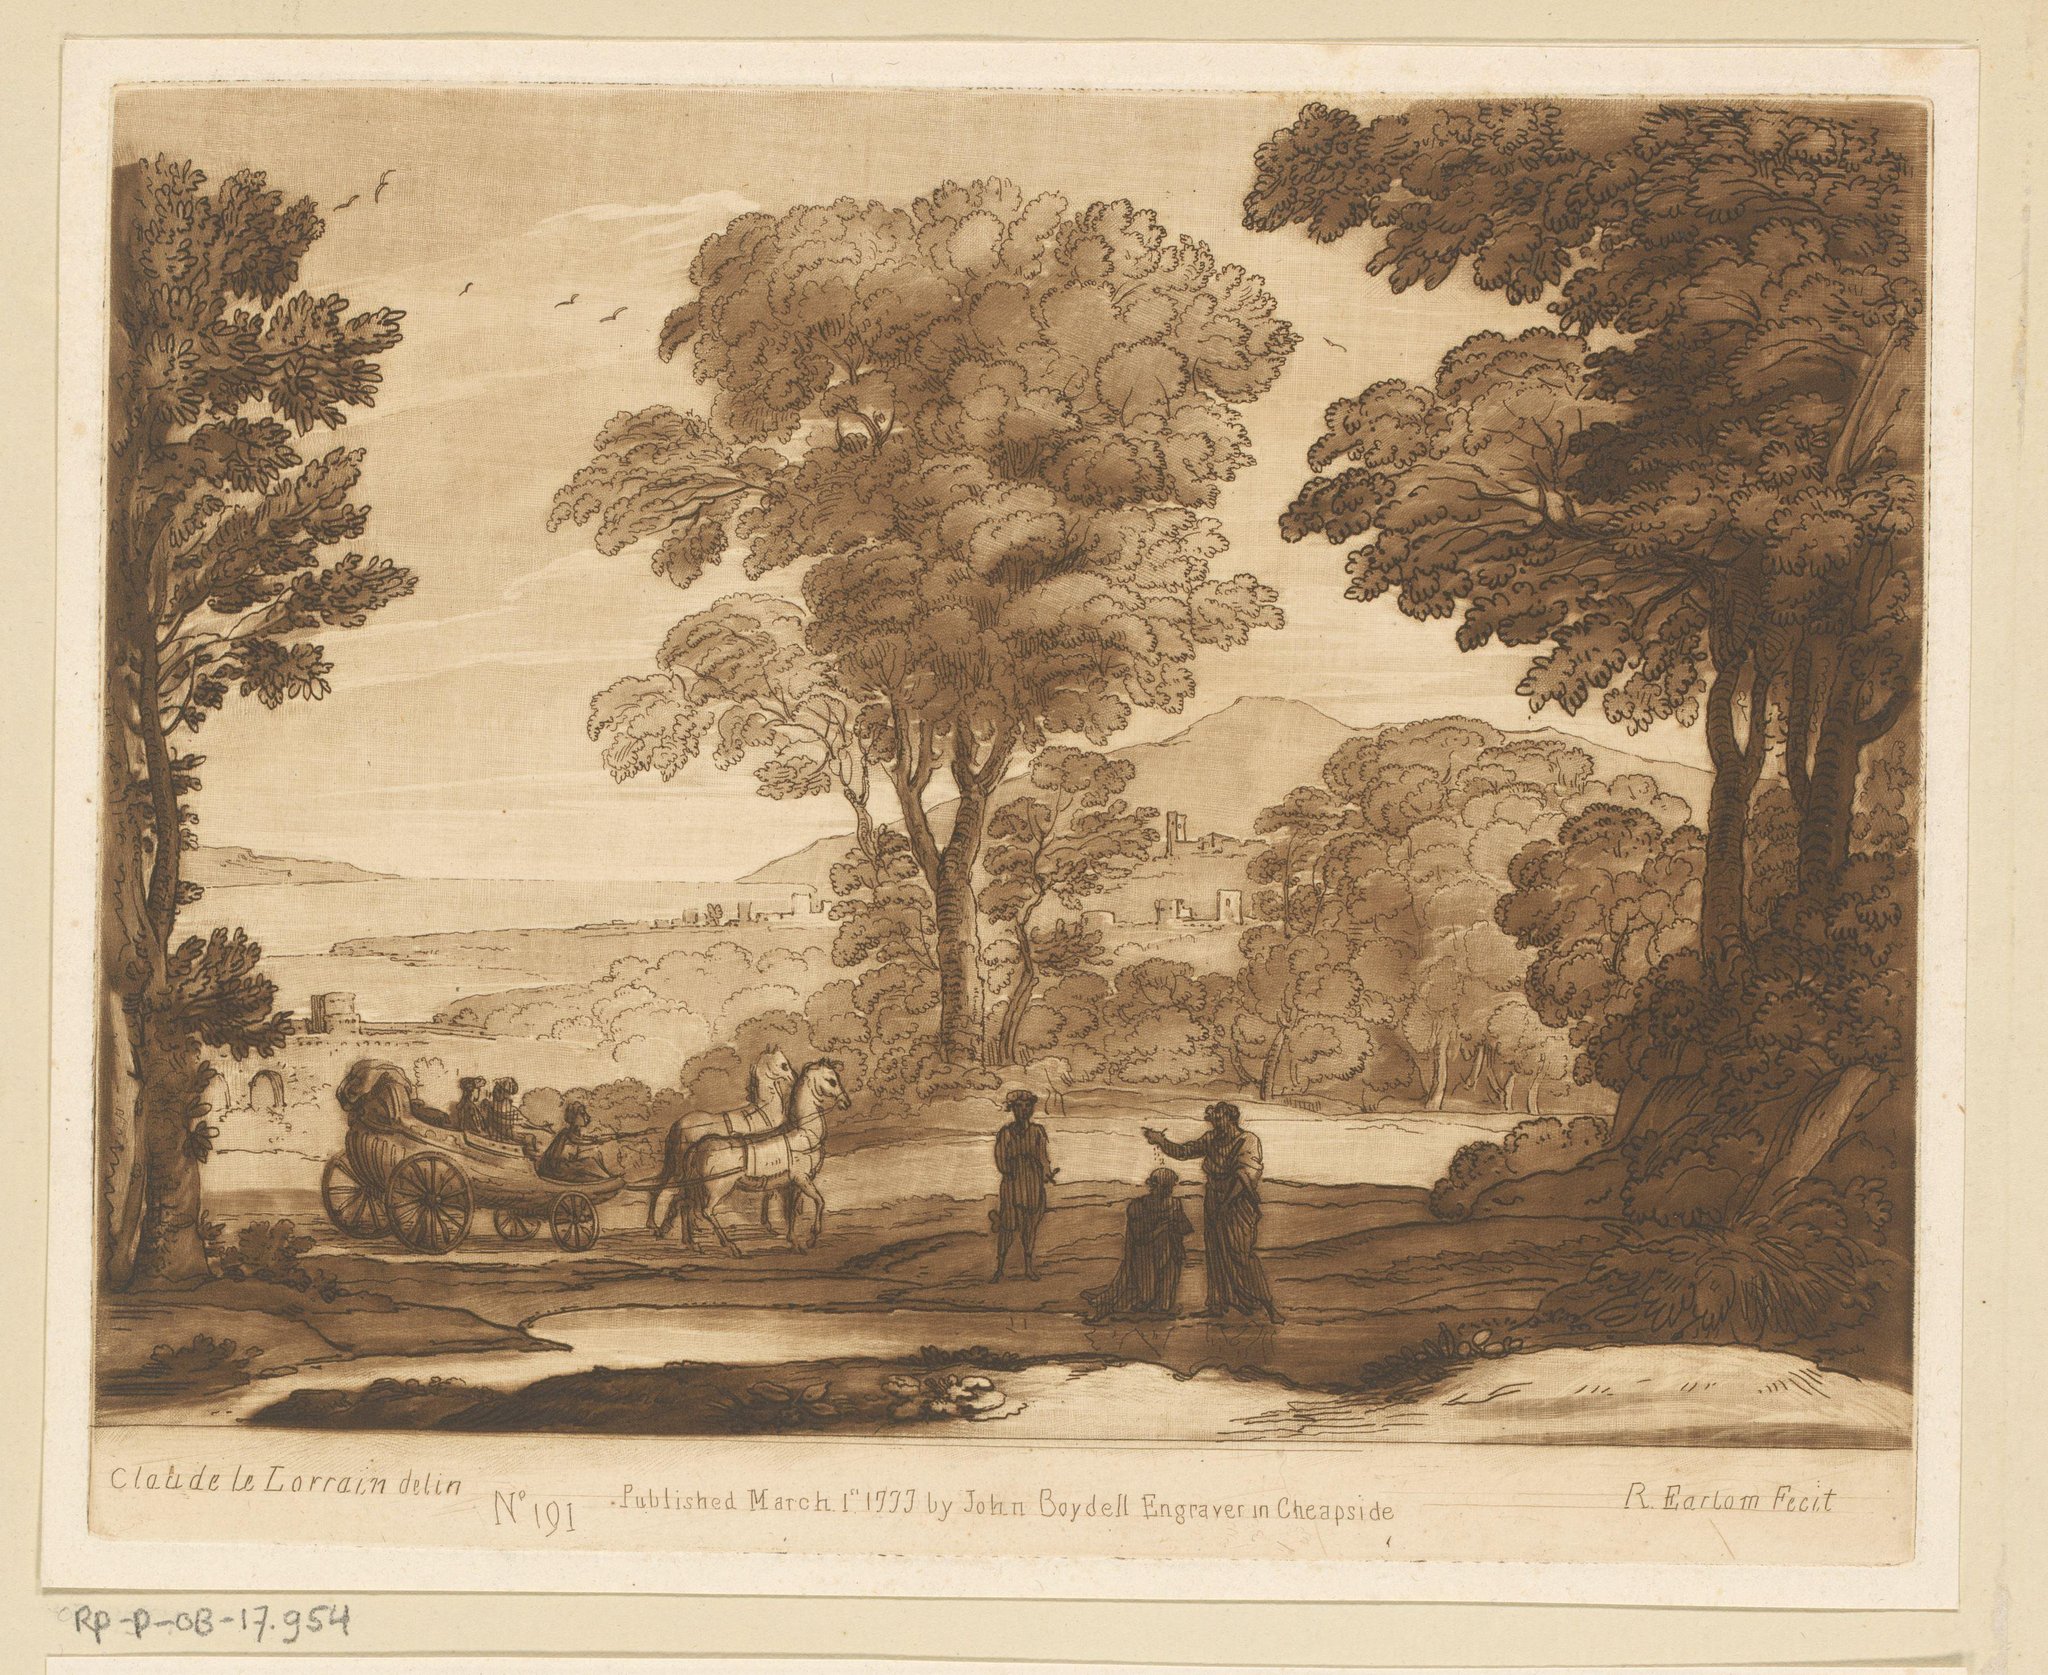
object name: print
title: Liber Veritatis. Or a Collection of Two Hundred Prints, after the original designs of Claude le Lorrain (...)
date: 1777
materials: paper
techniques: etching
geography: london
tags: river - hh - ideal landscapes, philip baptizes the eunuch, chariot, triumphal car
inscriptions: date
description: Vanaf 1774 publiceerde John Boydell tweehonderd prenten naar het tekeningenboek Liber Veritatis van Claude Lorrain, in het bezit van de hertogen van Cavendish. Deze prenten werden vanaf 1777 in twee volumes gebundeld uitgegeven.